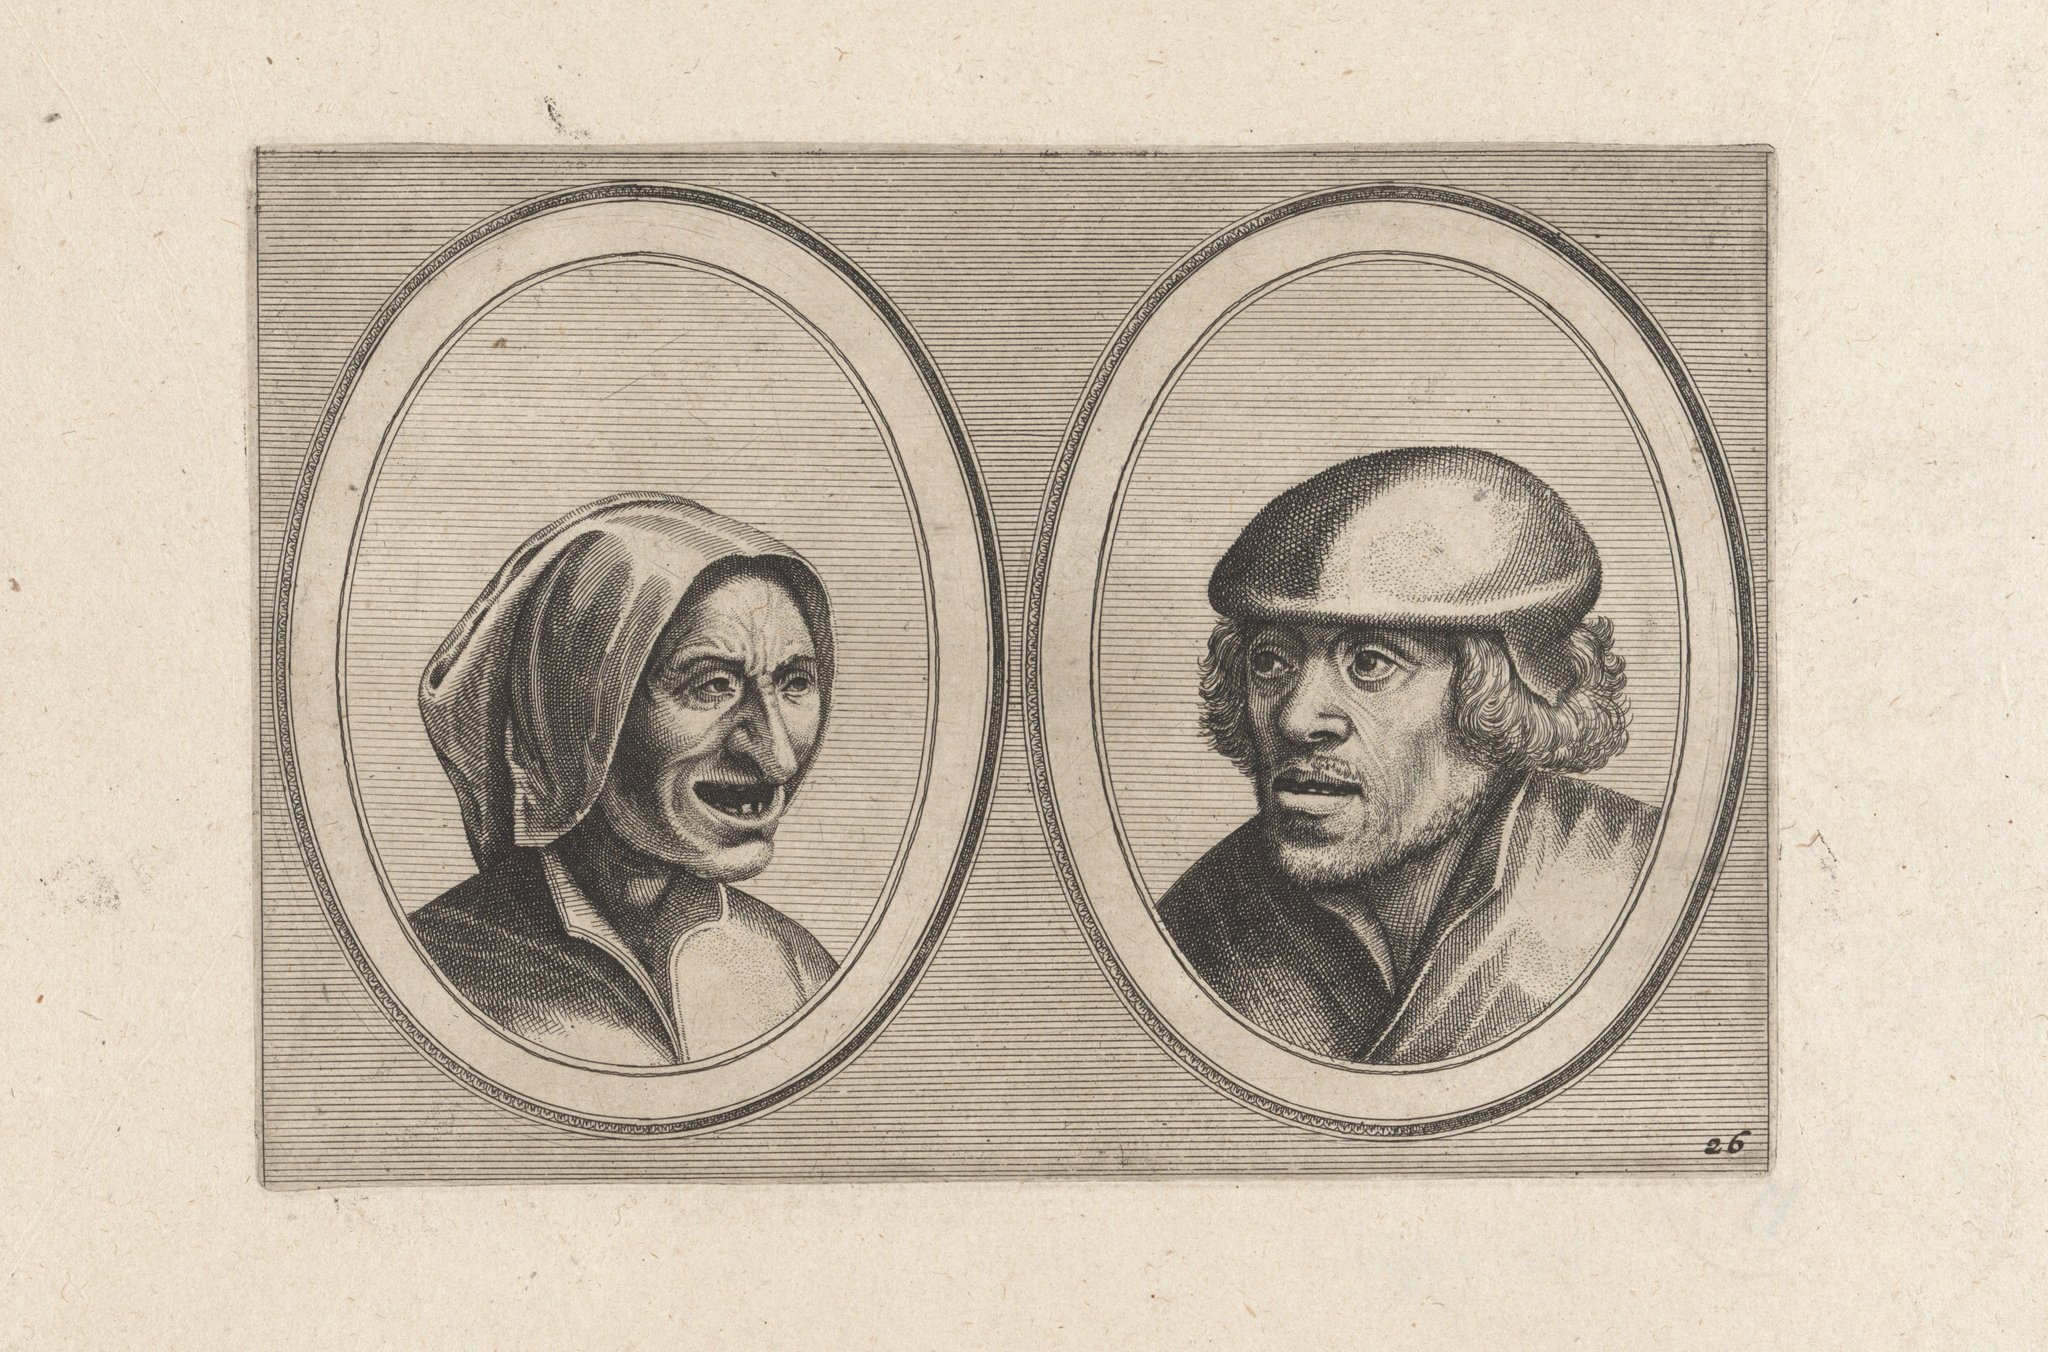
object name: print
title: Vrouw Verneem-al en Hans de Pluym-strijcker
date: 1612-1652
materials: paper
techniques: engraving, etching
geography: amsterdam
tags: head-gear, farmers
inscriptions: collector's mark: Lugt 700, collector's mark: Lugt 240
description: Prent uit een serie van 36 prenten met koppen van boeren en boerinnen.